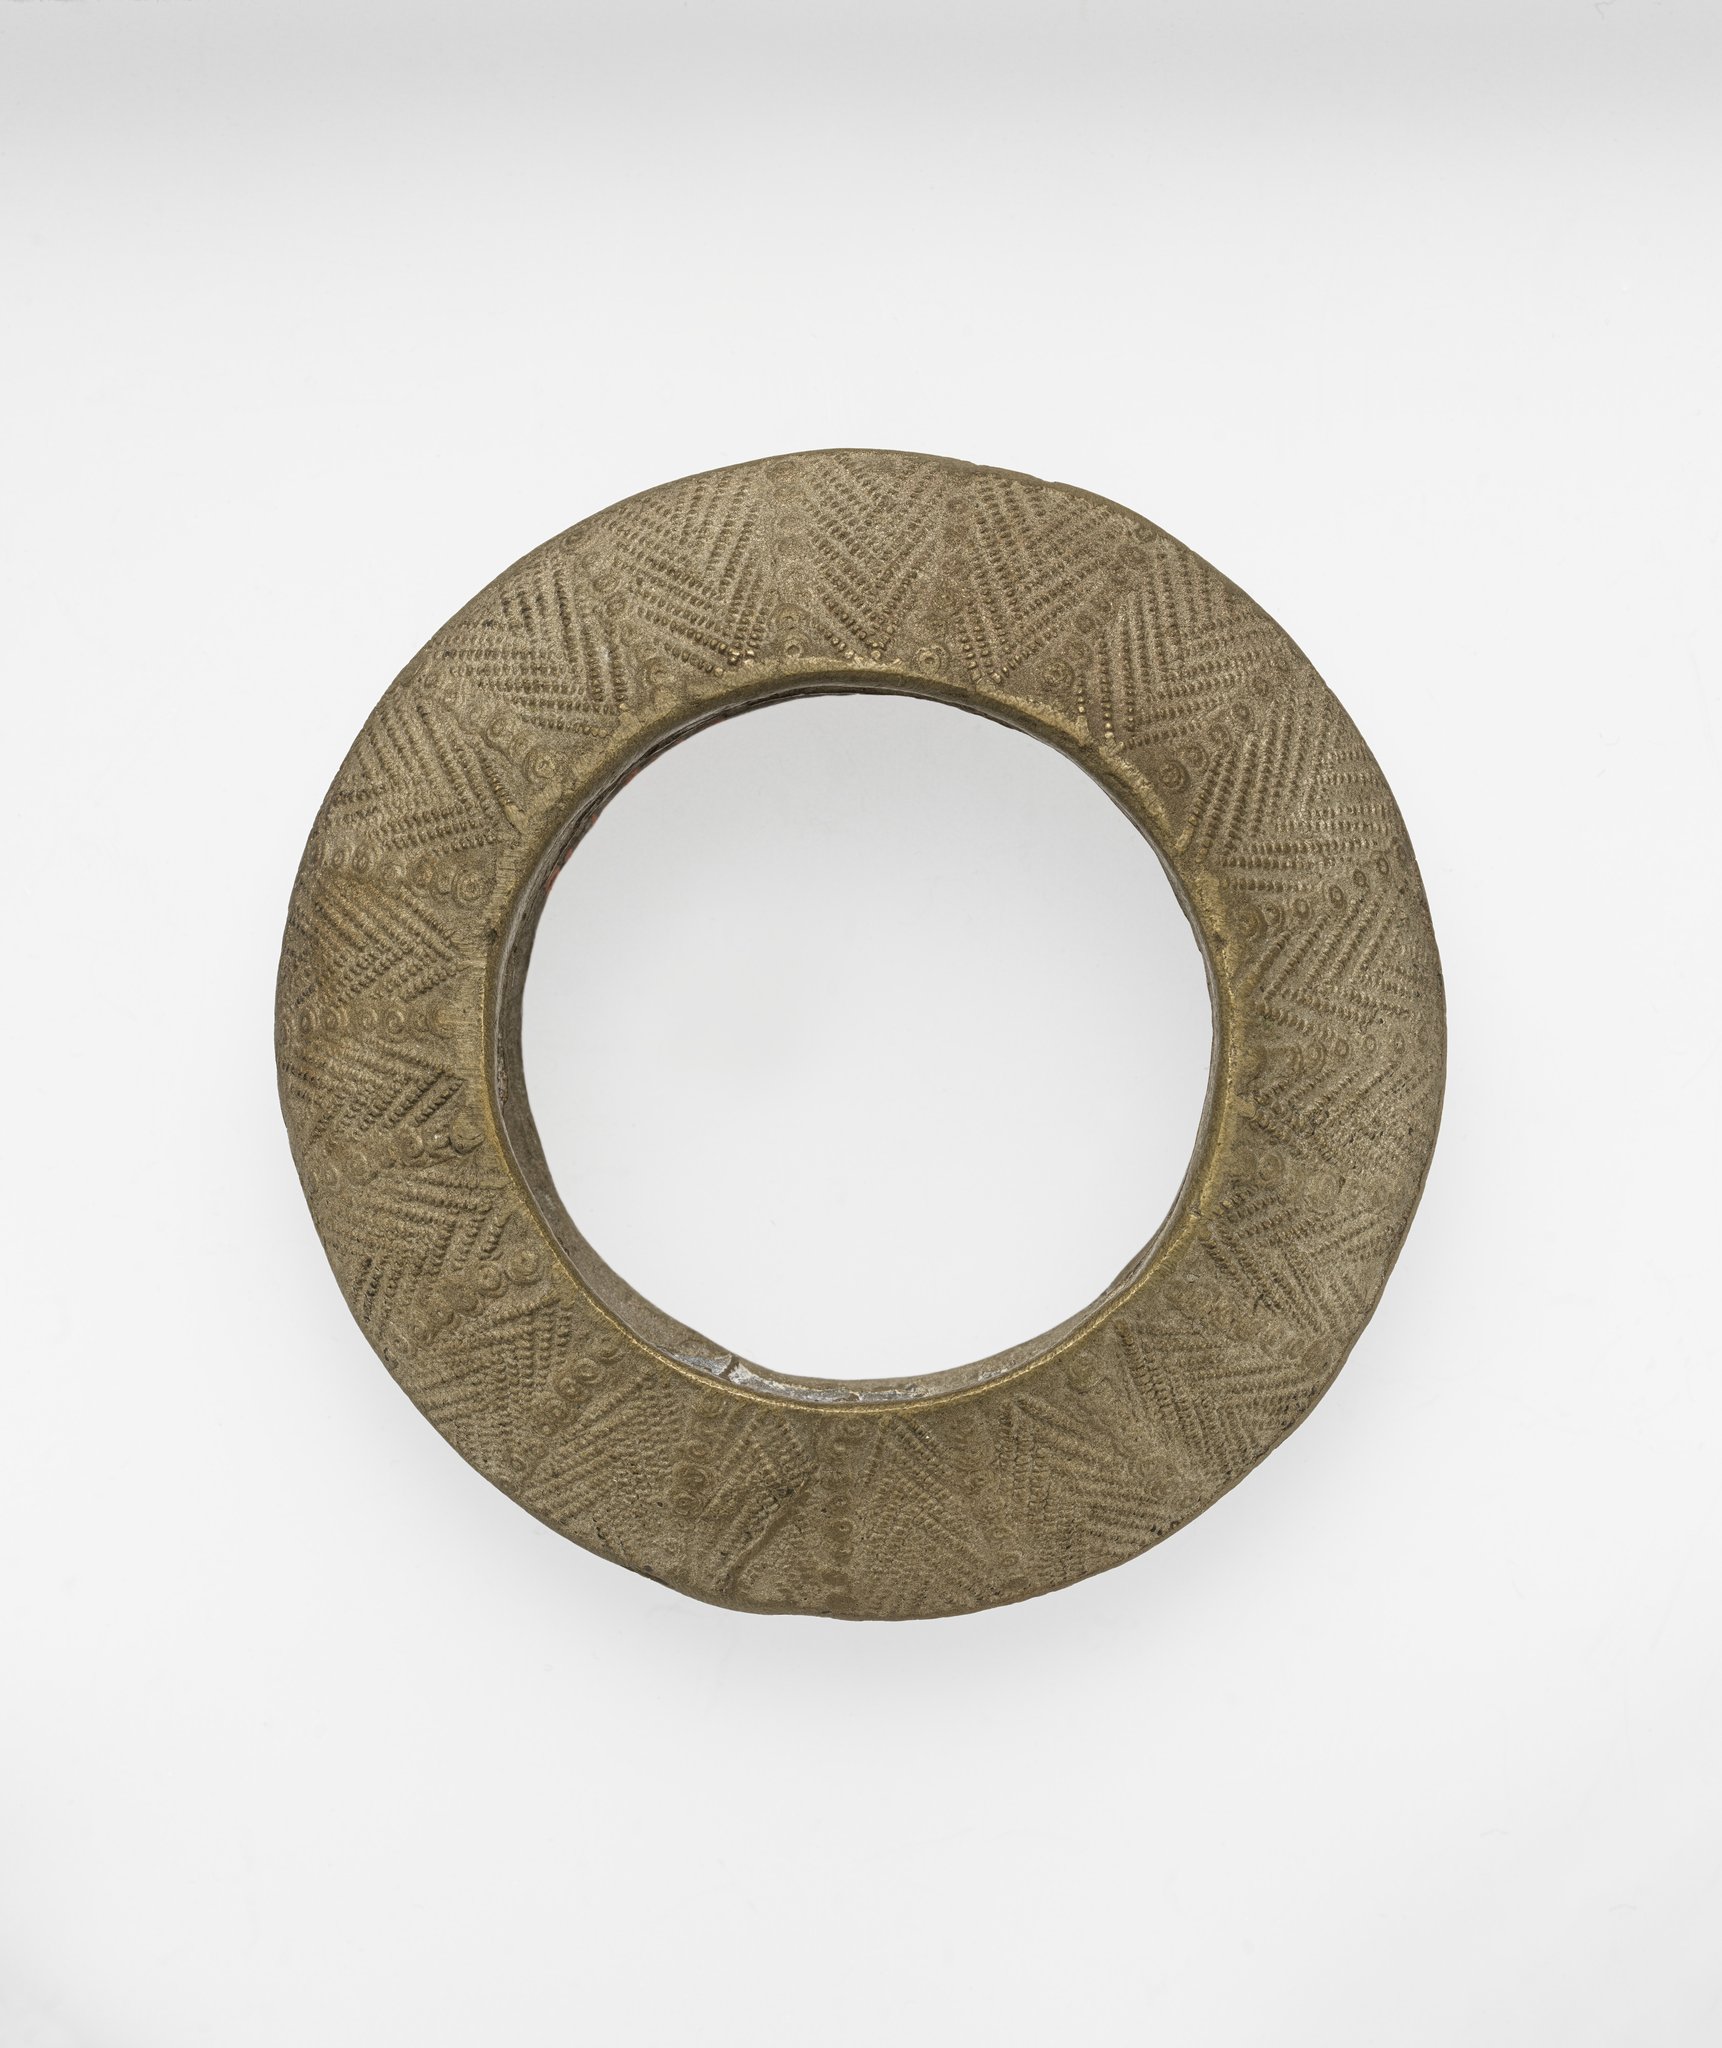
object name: anklet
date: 1801-1900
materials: iron, silver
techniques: casting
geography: india